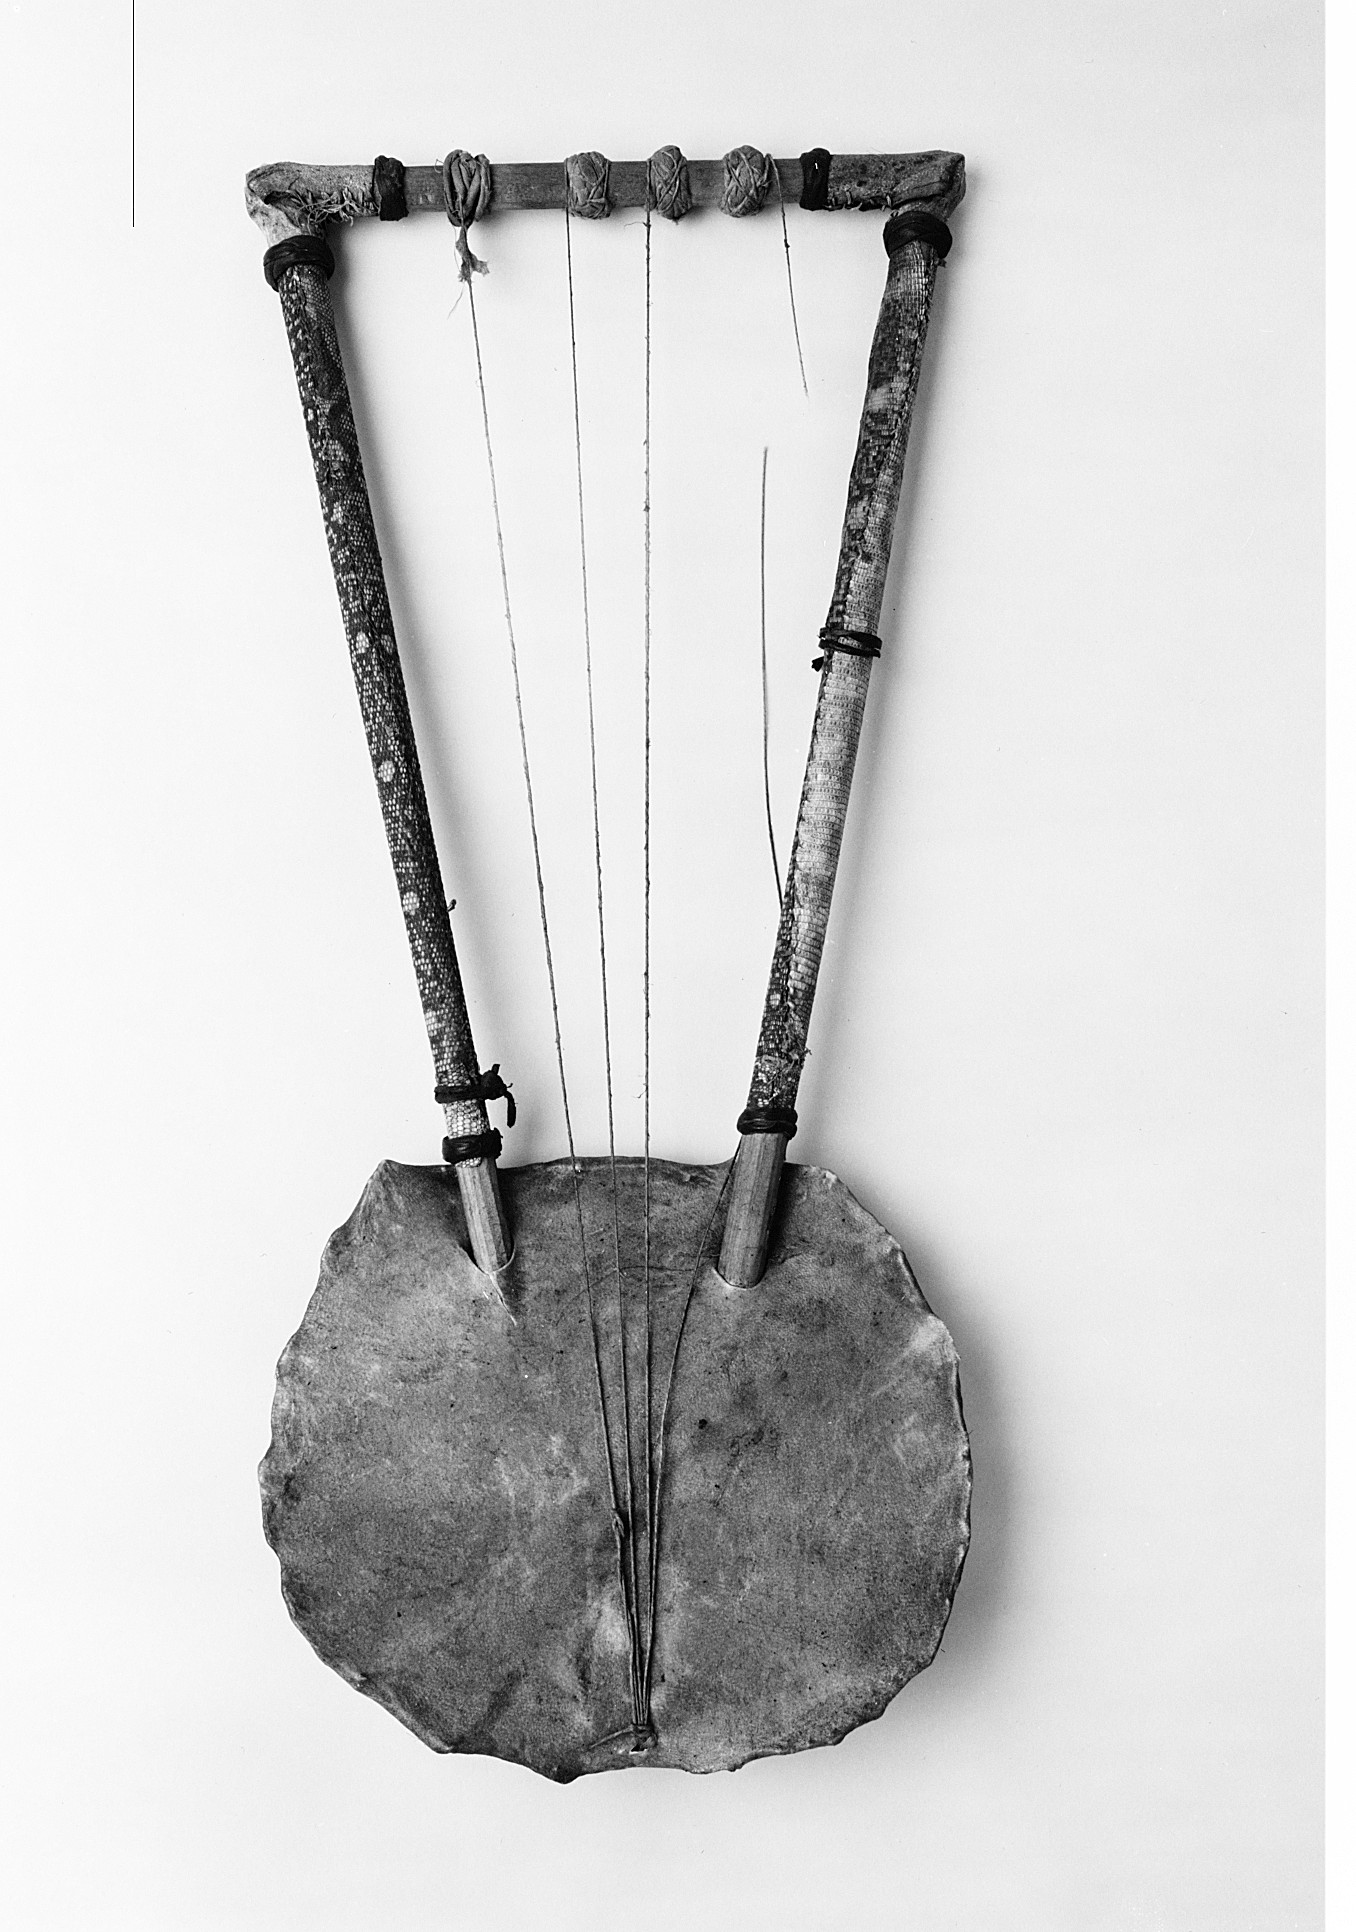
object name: bowl lyre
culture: ethiopian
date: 1801-1900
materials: leather, skin, shell, wood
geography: ethiopia